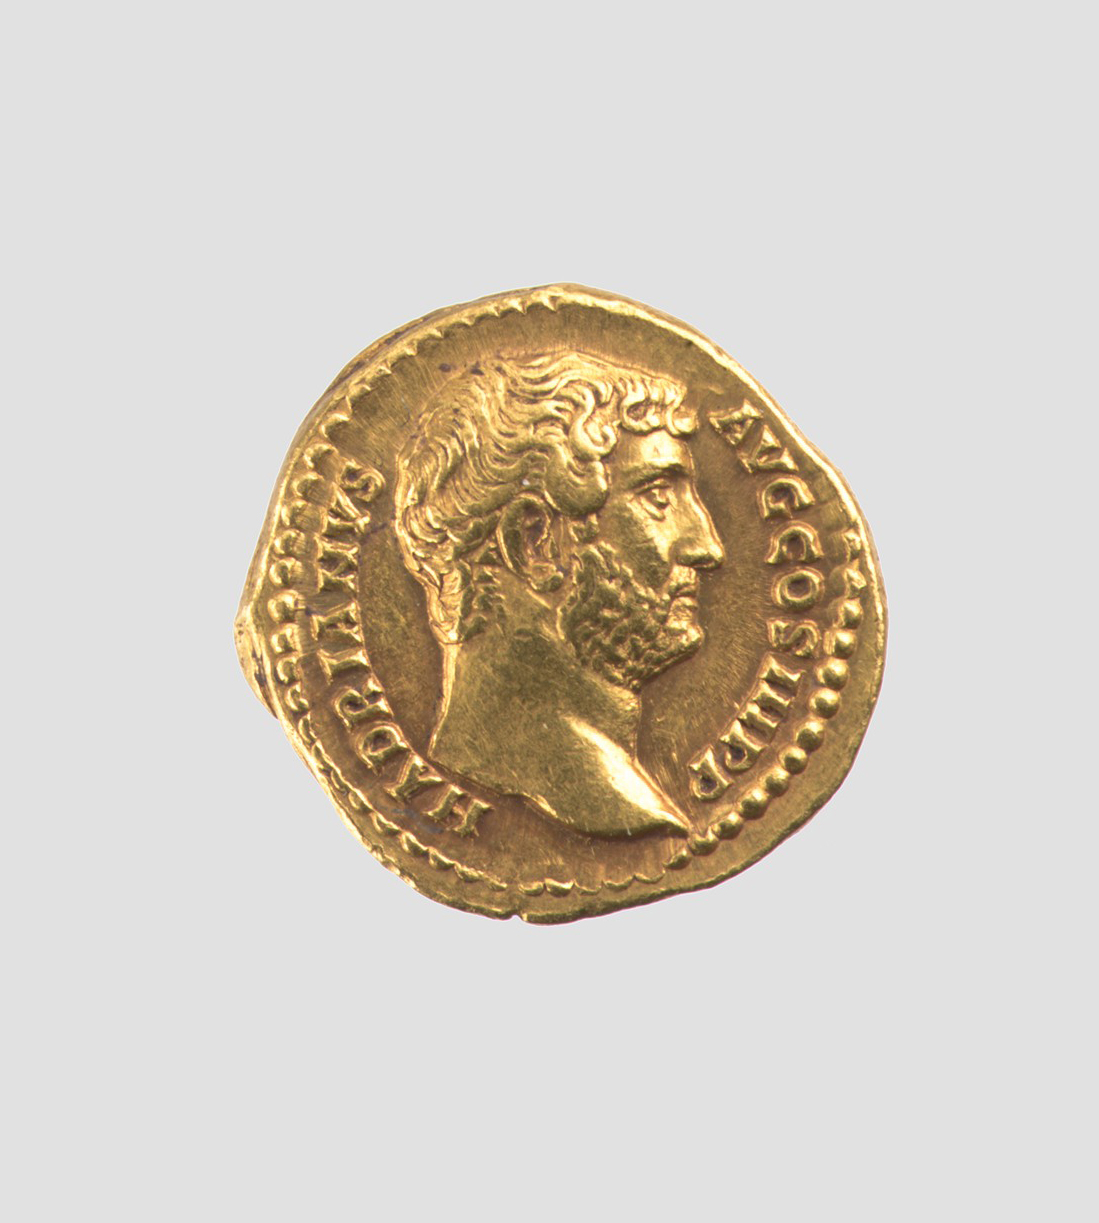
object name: aureus of hadrian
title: Gold aureus of Hadrian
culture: roman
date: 134-138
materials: gold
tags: men,profiles